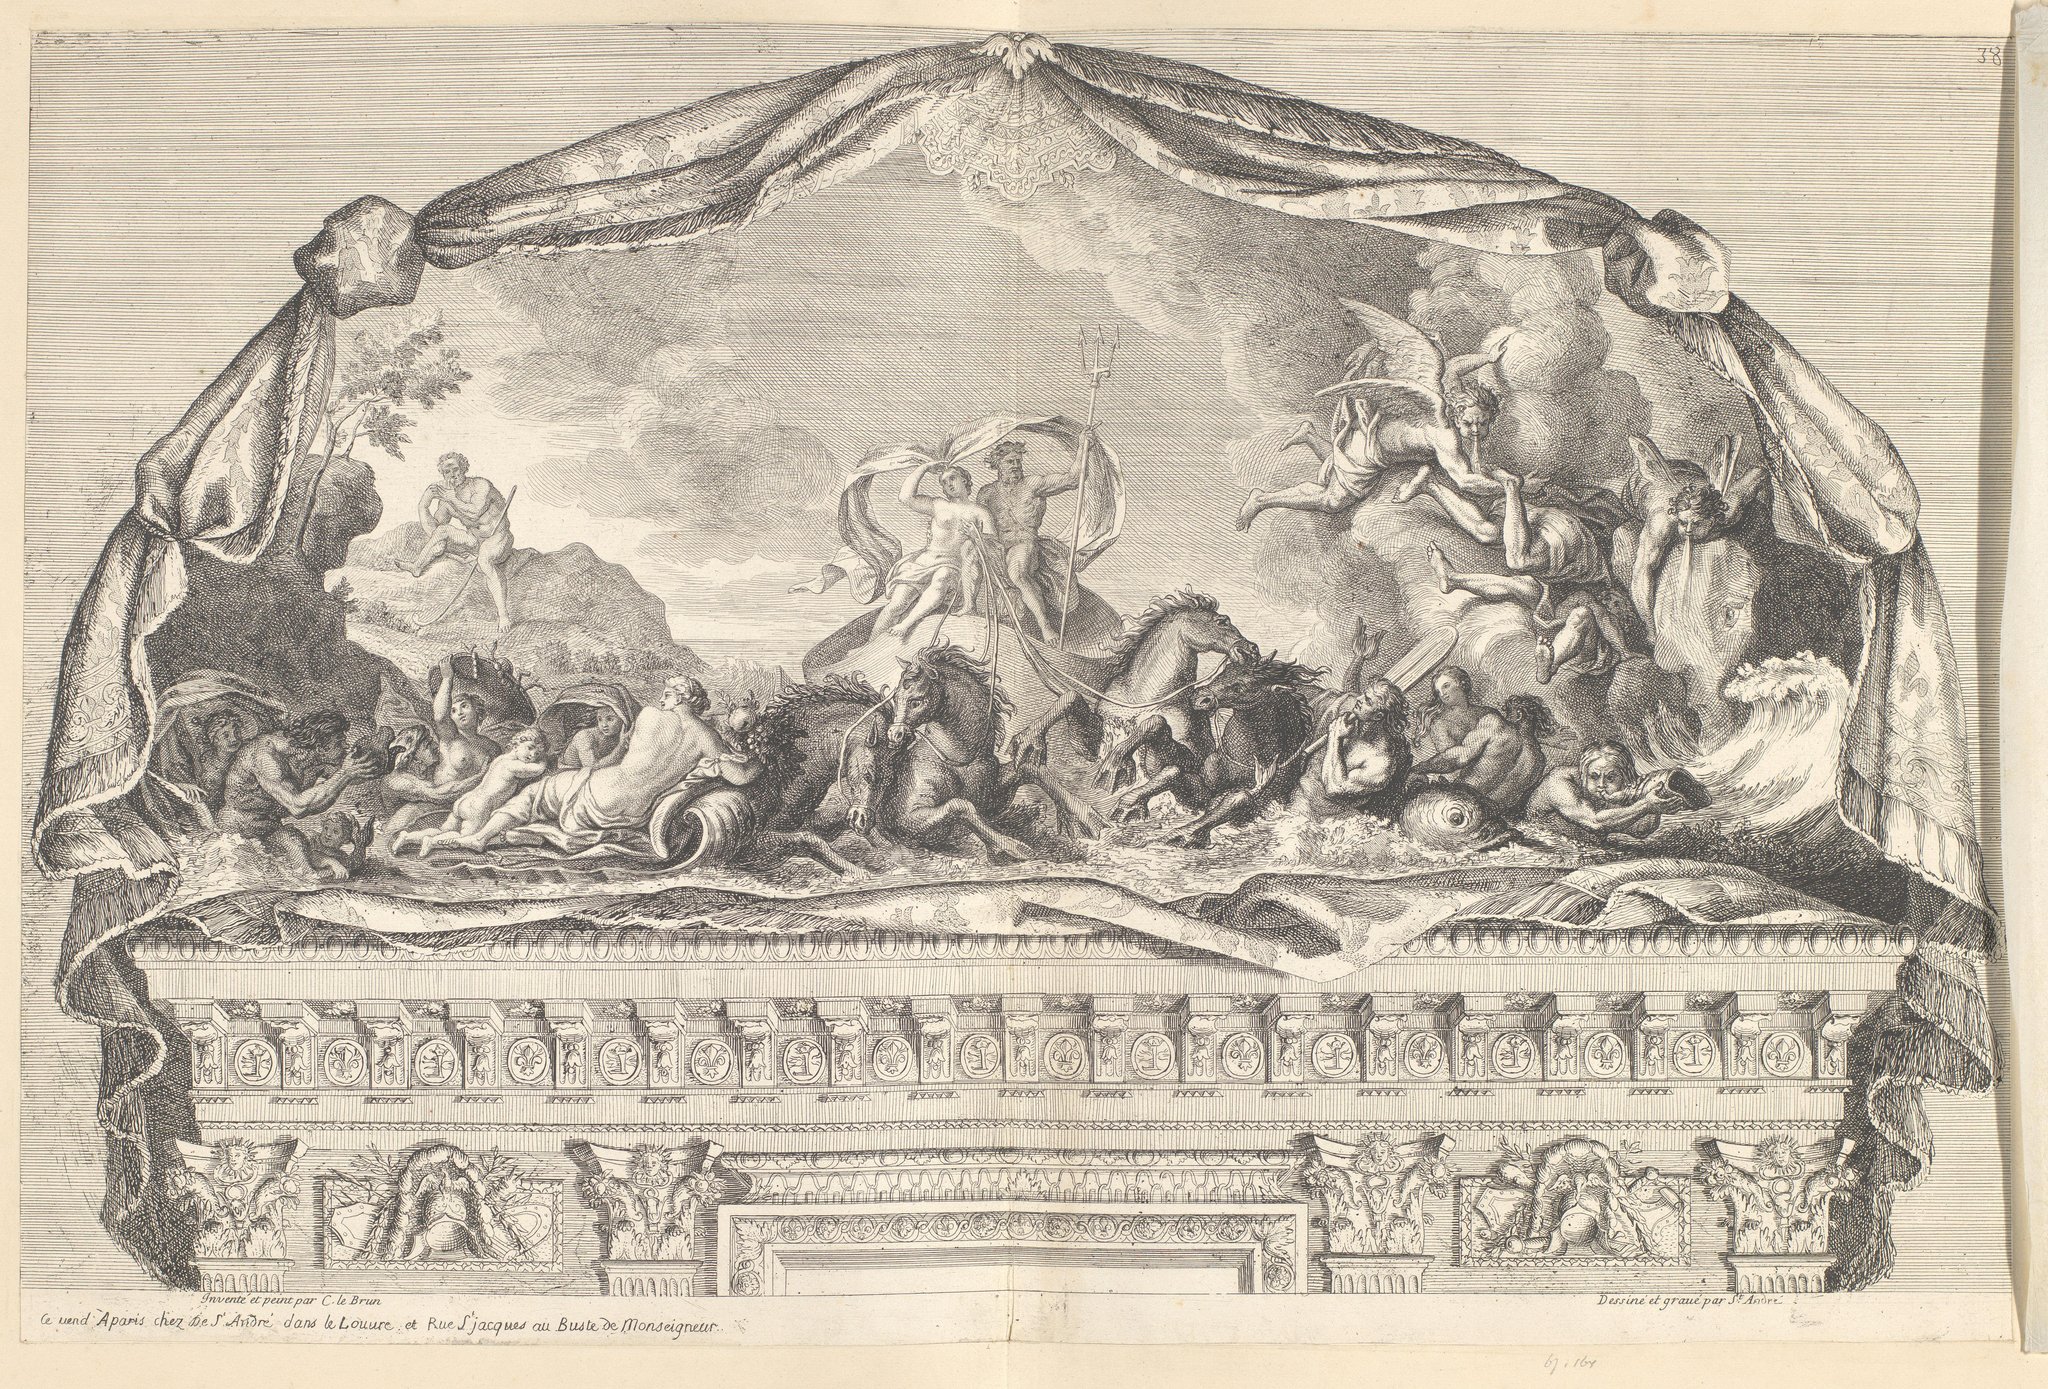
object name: album leaf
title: La Petite Gallerie du Louvre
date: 1695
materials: paper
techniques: etching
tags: ornaments ~ art, the cyclopes, gods of the winds, neptune as lord of the sea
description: Allegorie op Neptunus en de zee. Deze prent maakt deel uit van een album.